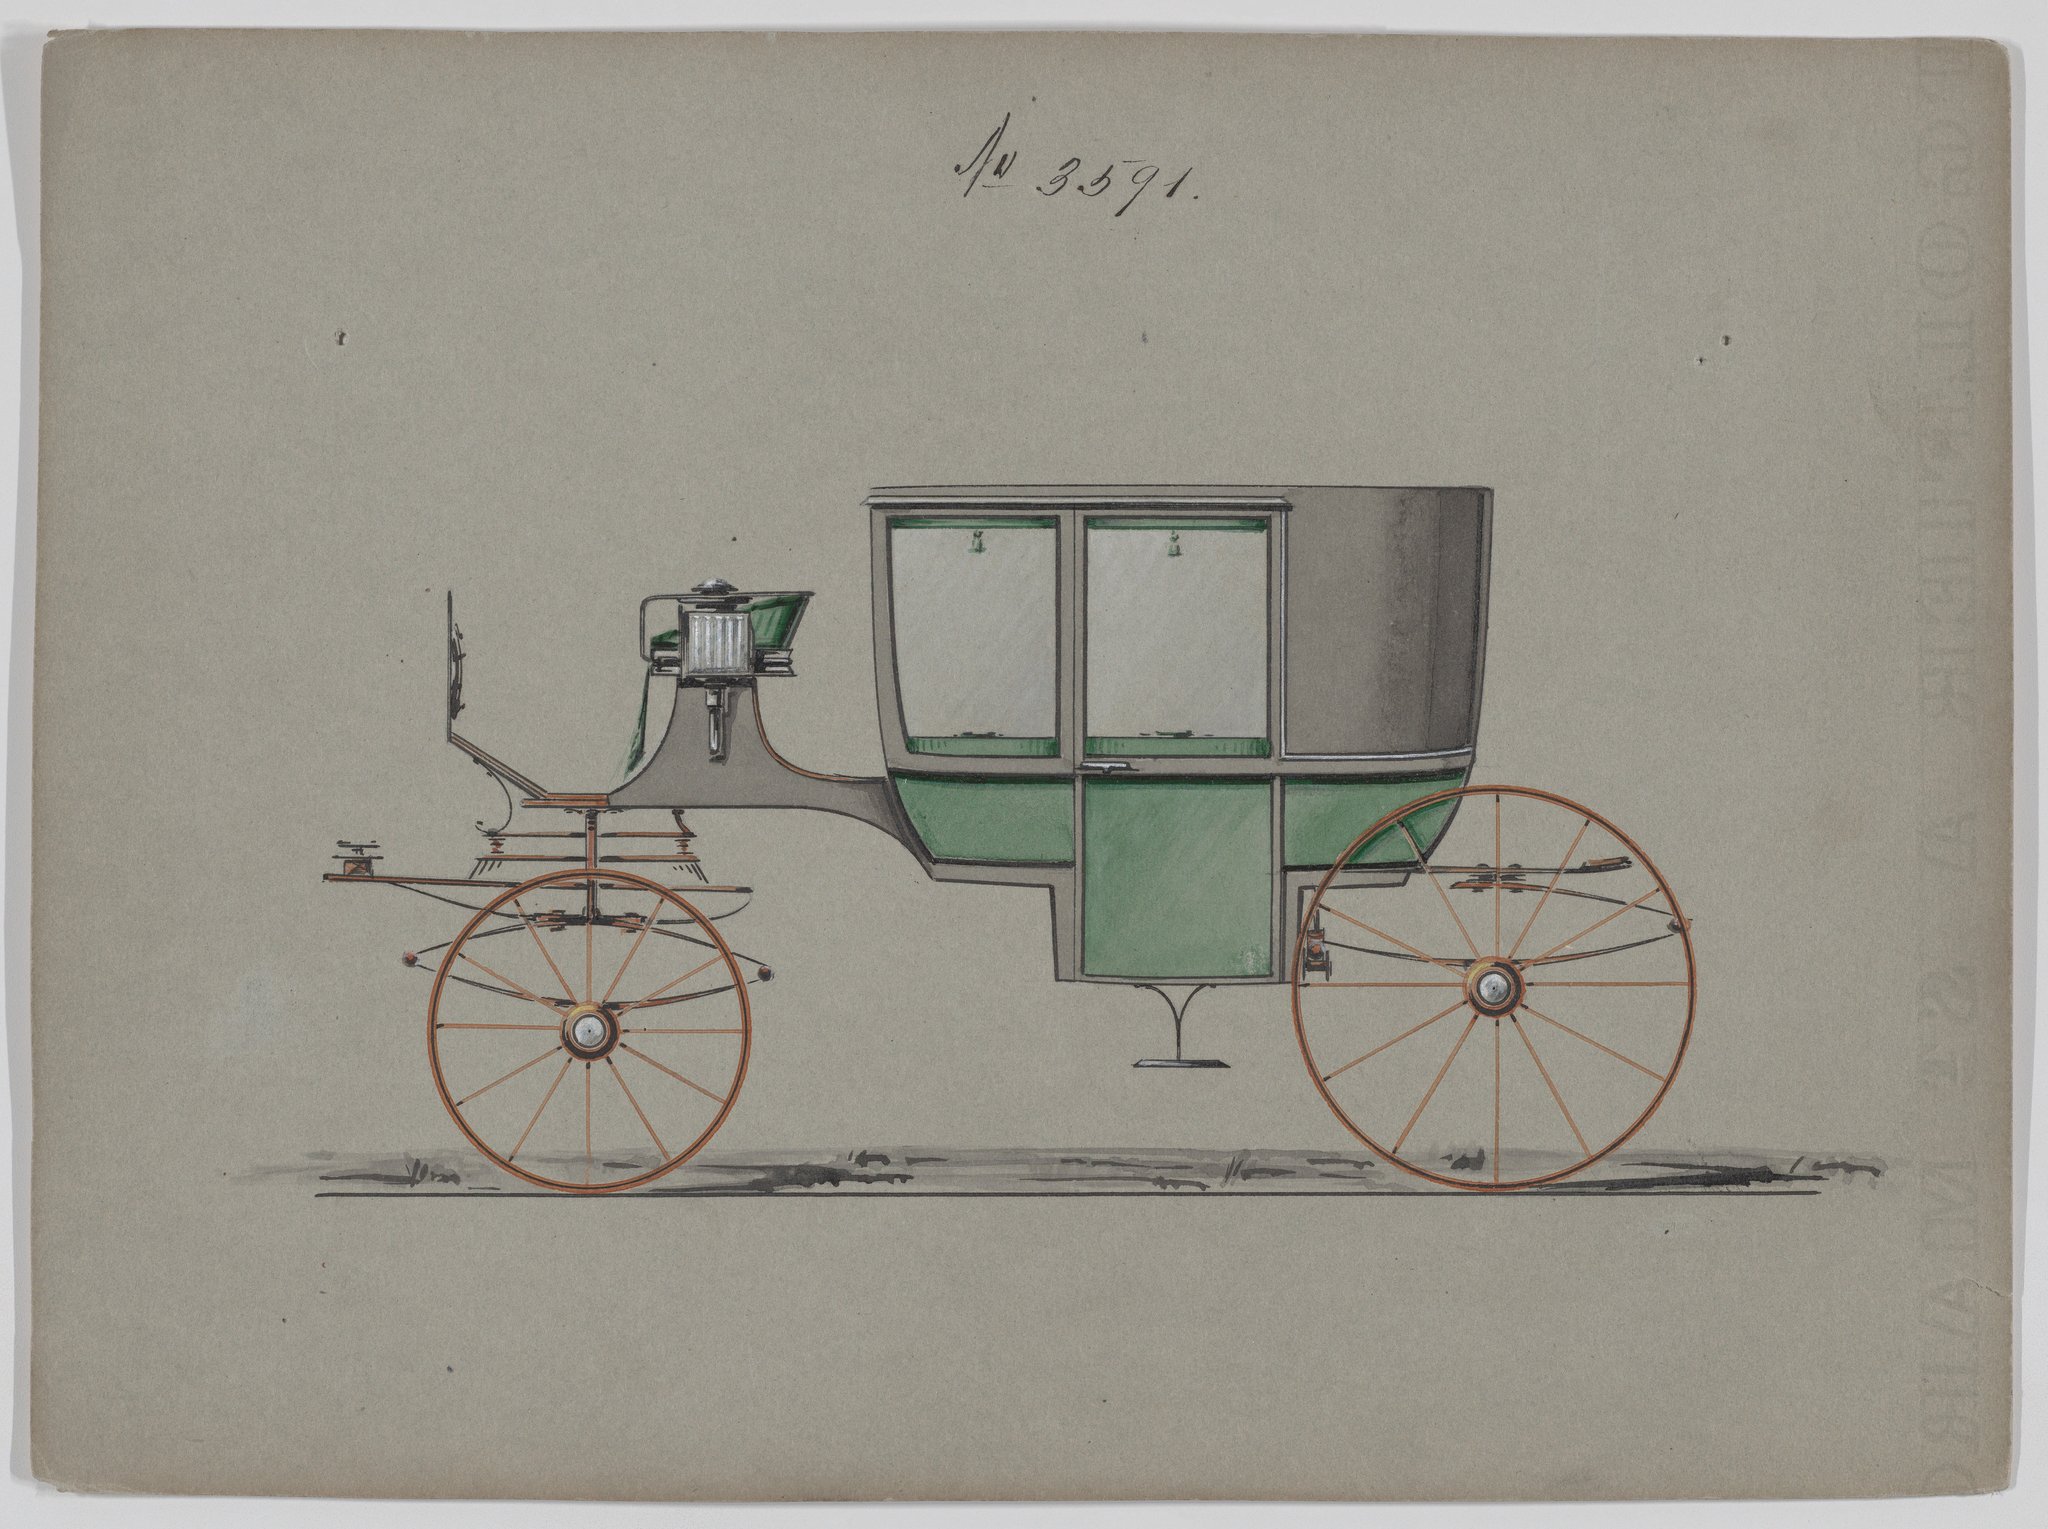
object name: drawing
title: Coach #3591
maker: brewster & co.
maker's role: manufacturer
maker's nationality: american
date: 1880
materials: gouache, gum arabic, ink, watercolor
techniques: pen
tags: carriages